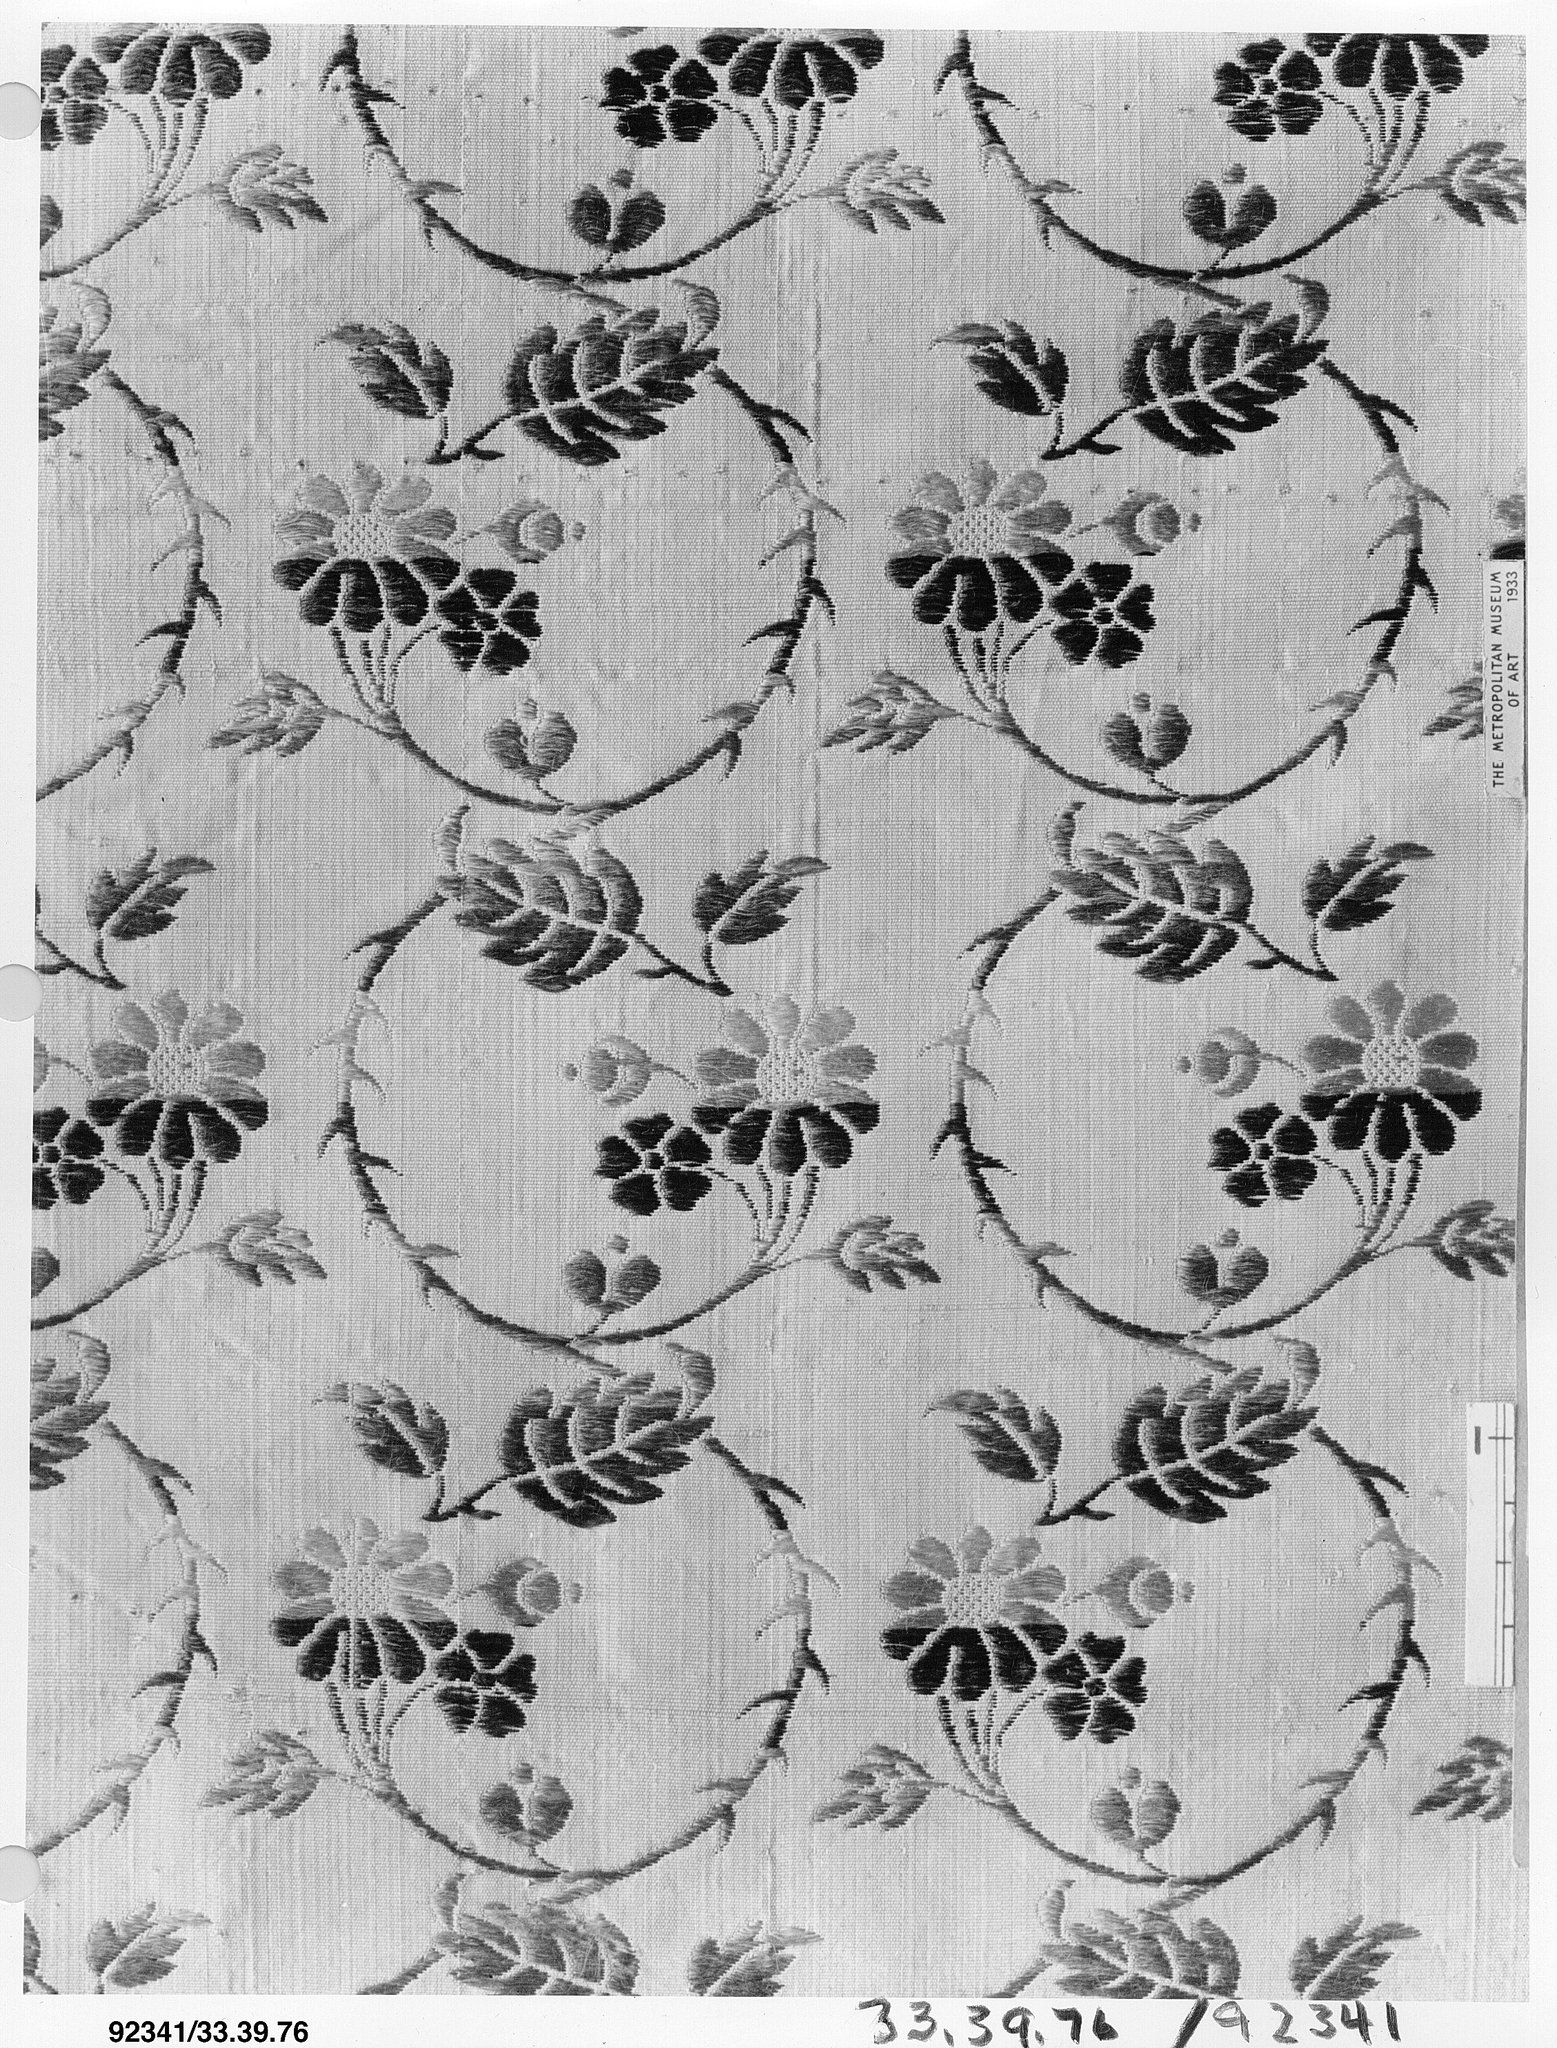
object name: fragment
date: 1800-1850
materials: silk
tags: flowers,leaves